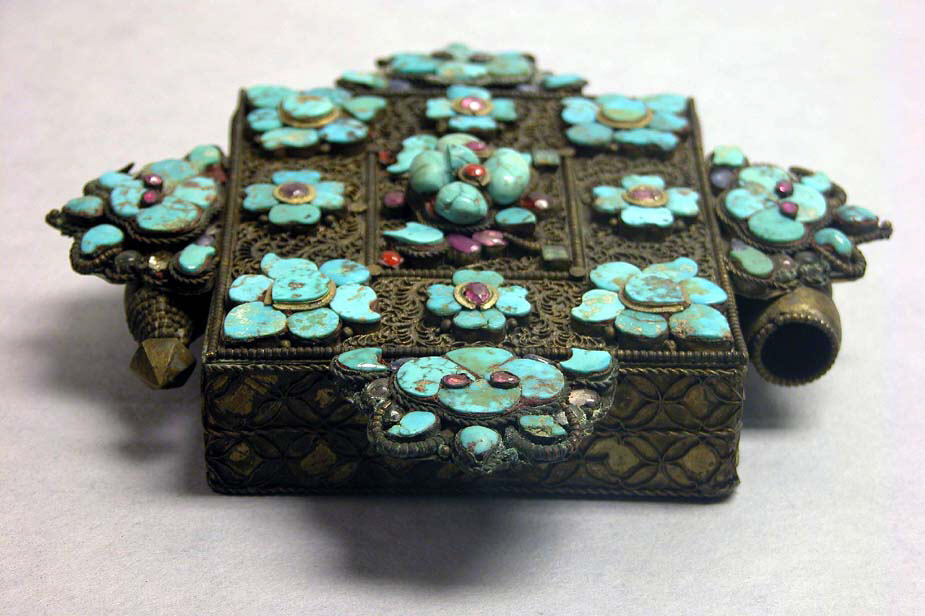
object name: case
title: Amulet Case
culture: tibetan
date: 1601-1900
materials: gold, stone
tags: flowers